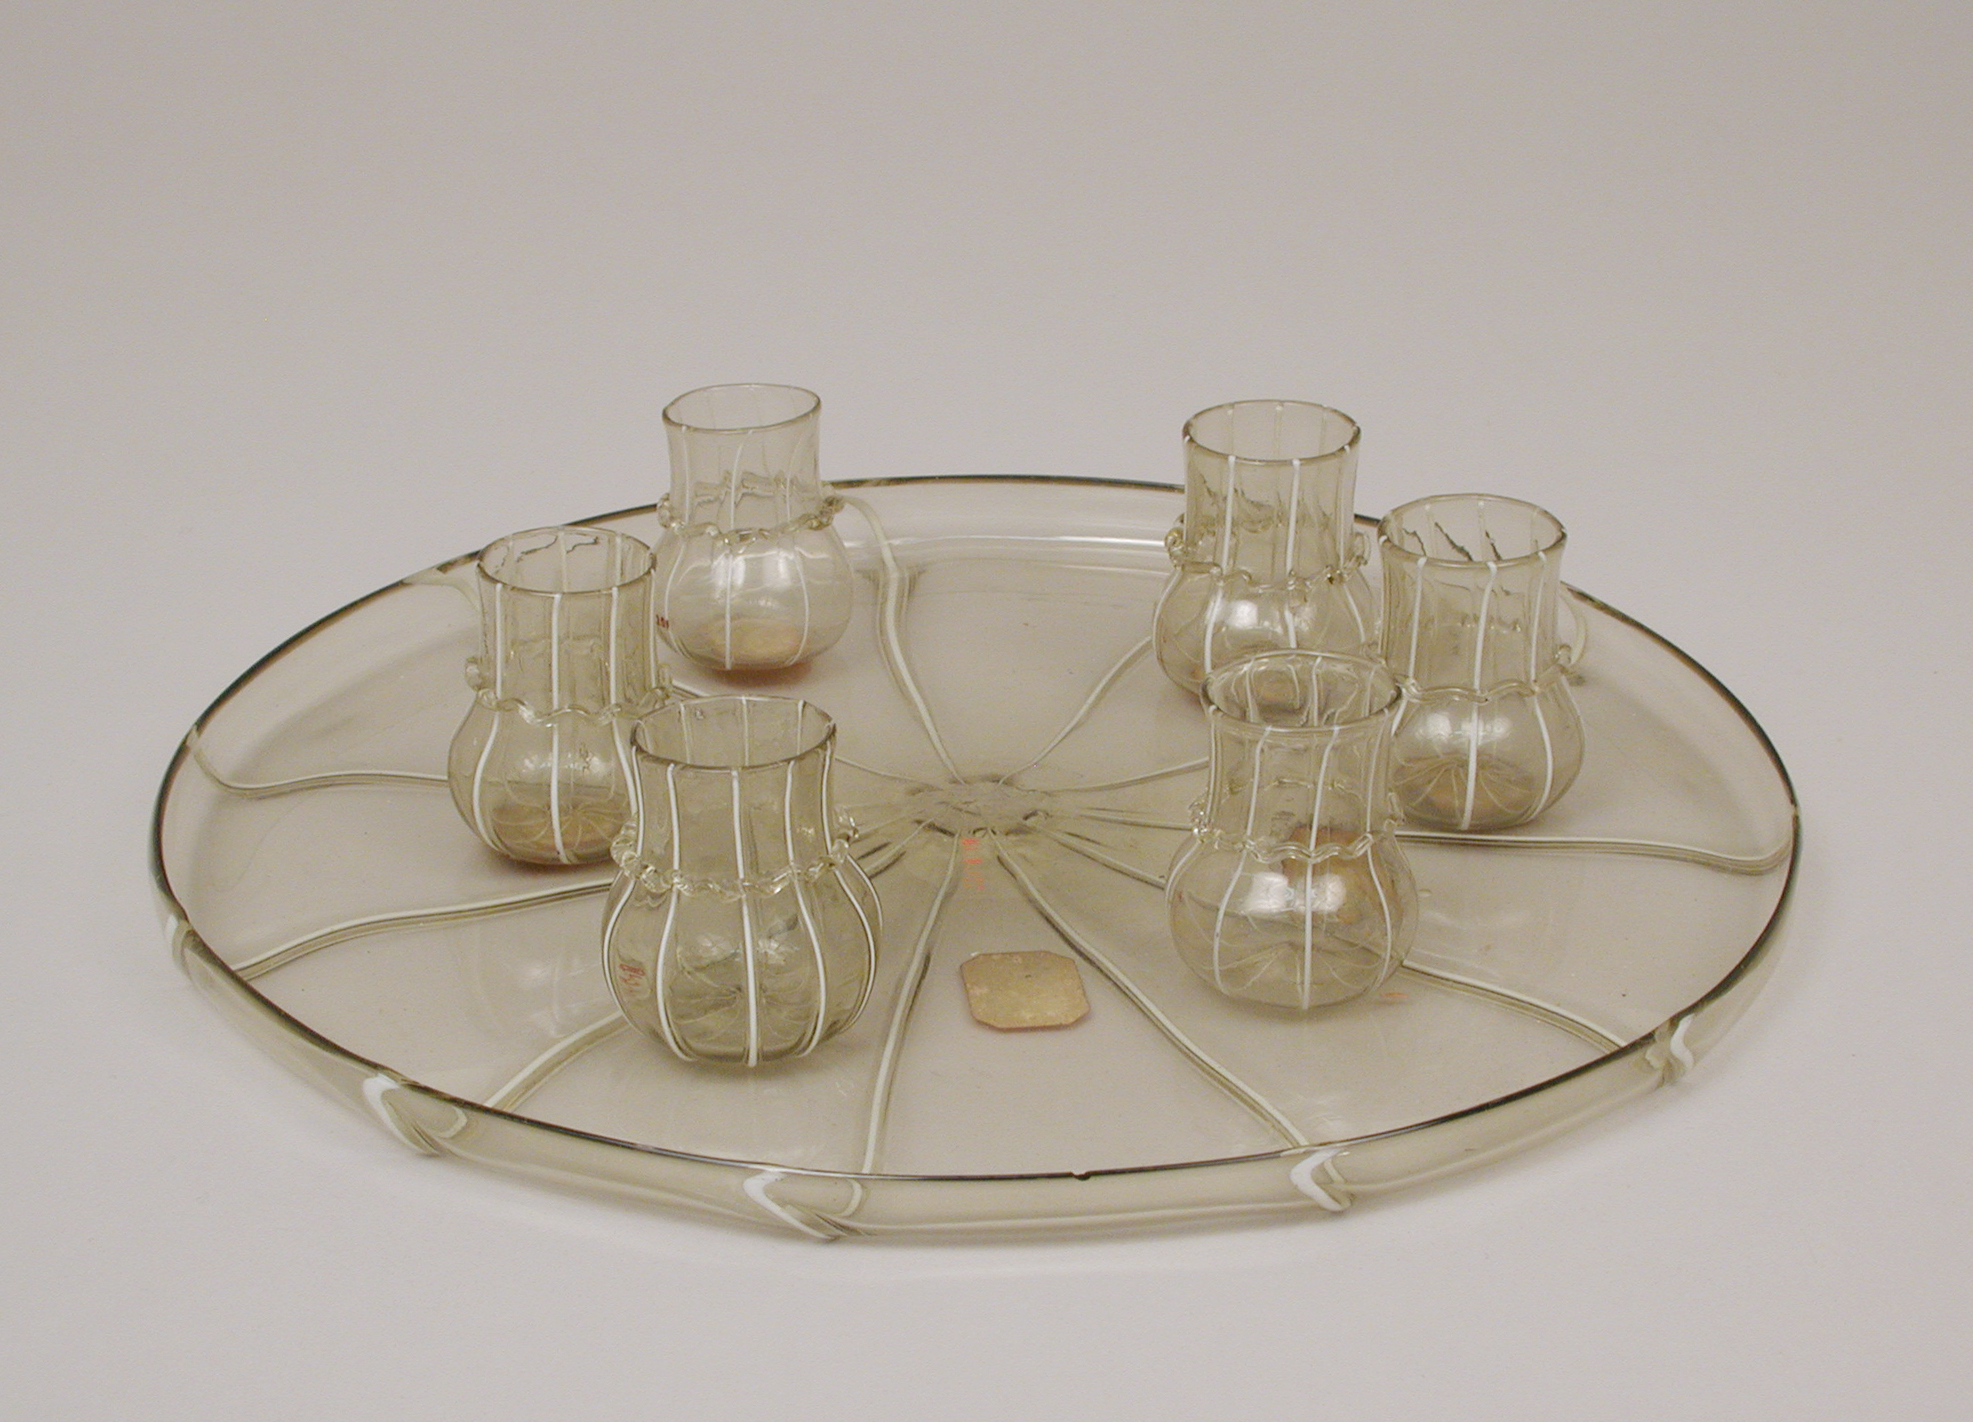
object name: plate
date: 1701-1900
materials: glass